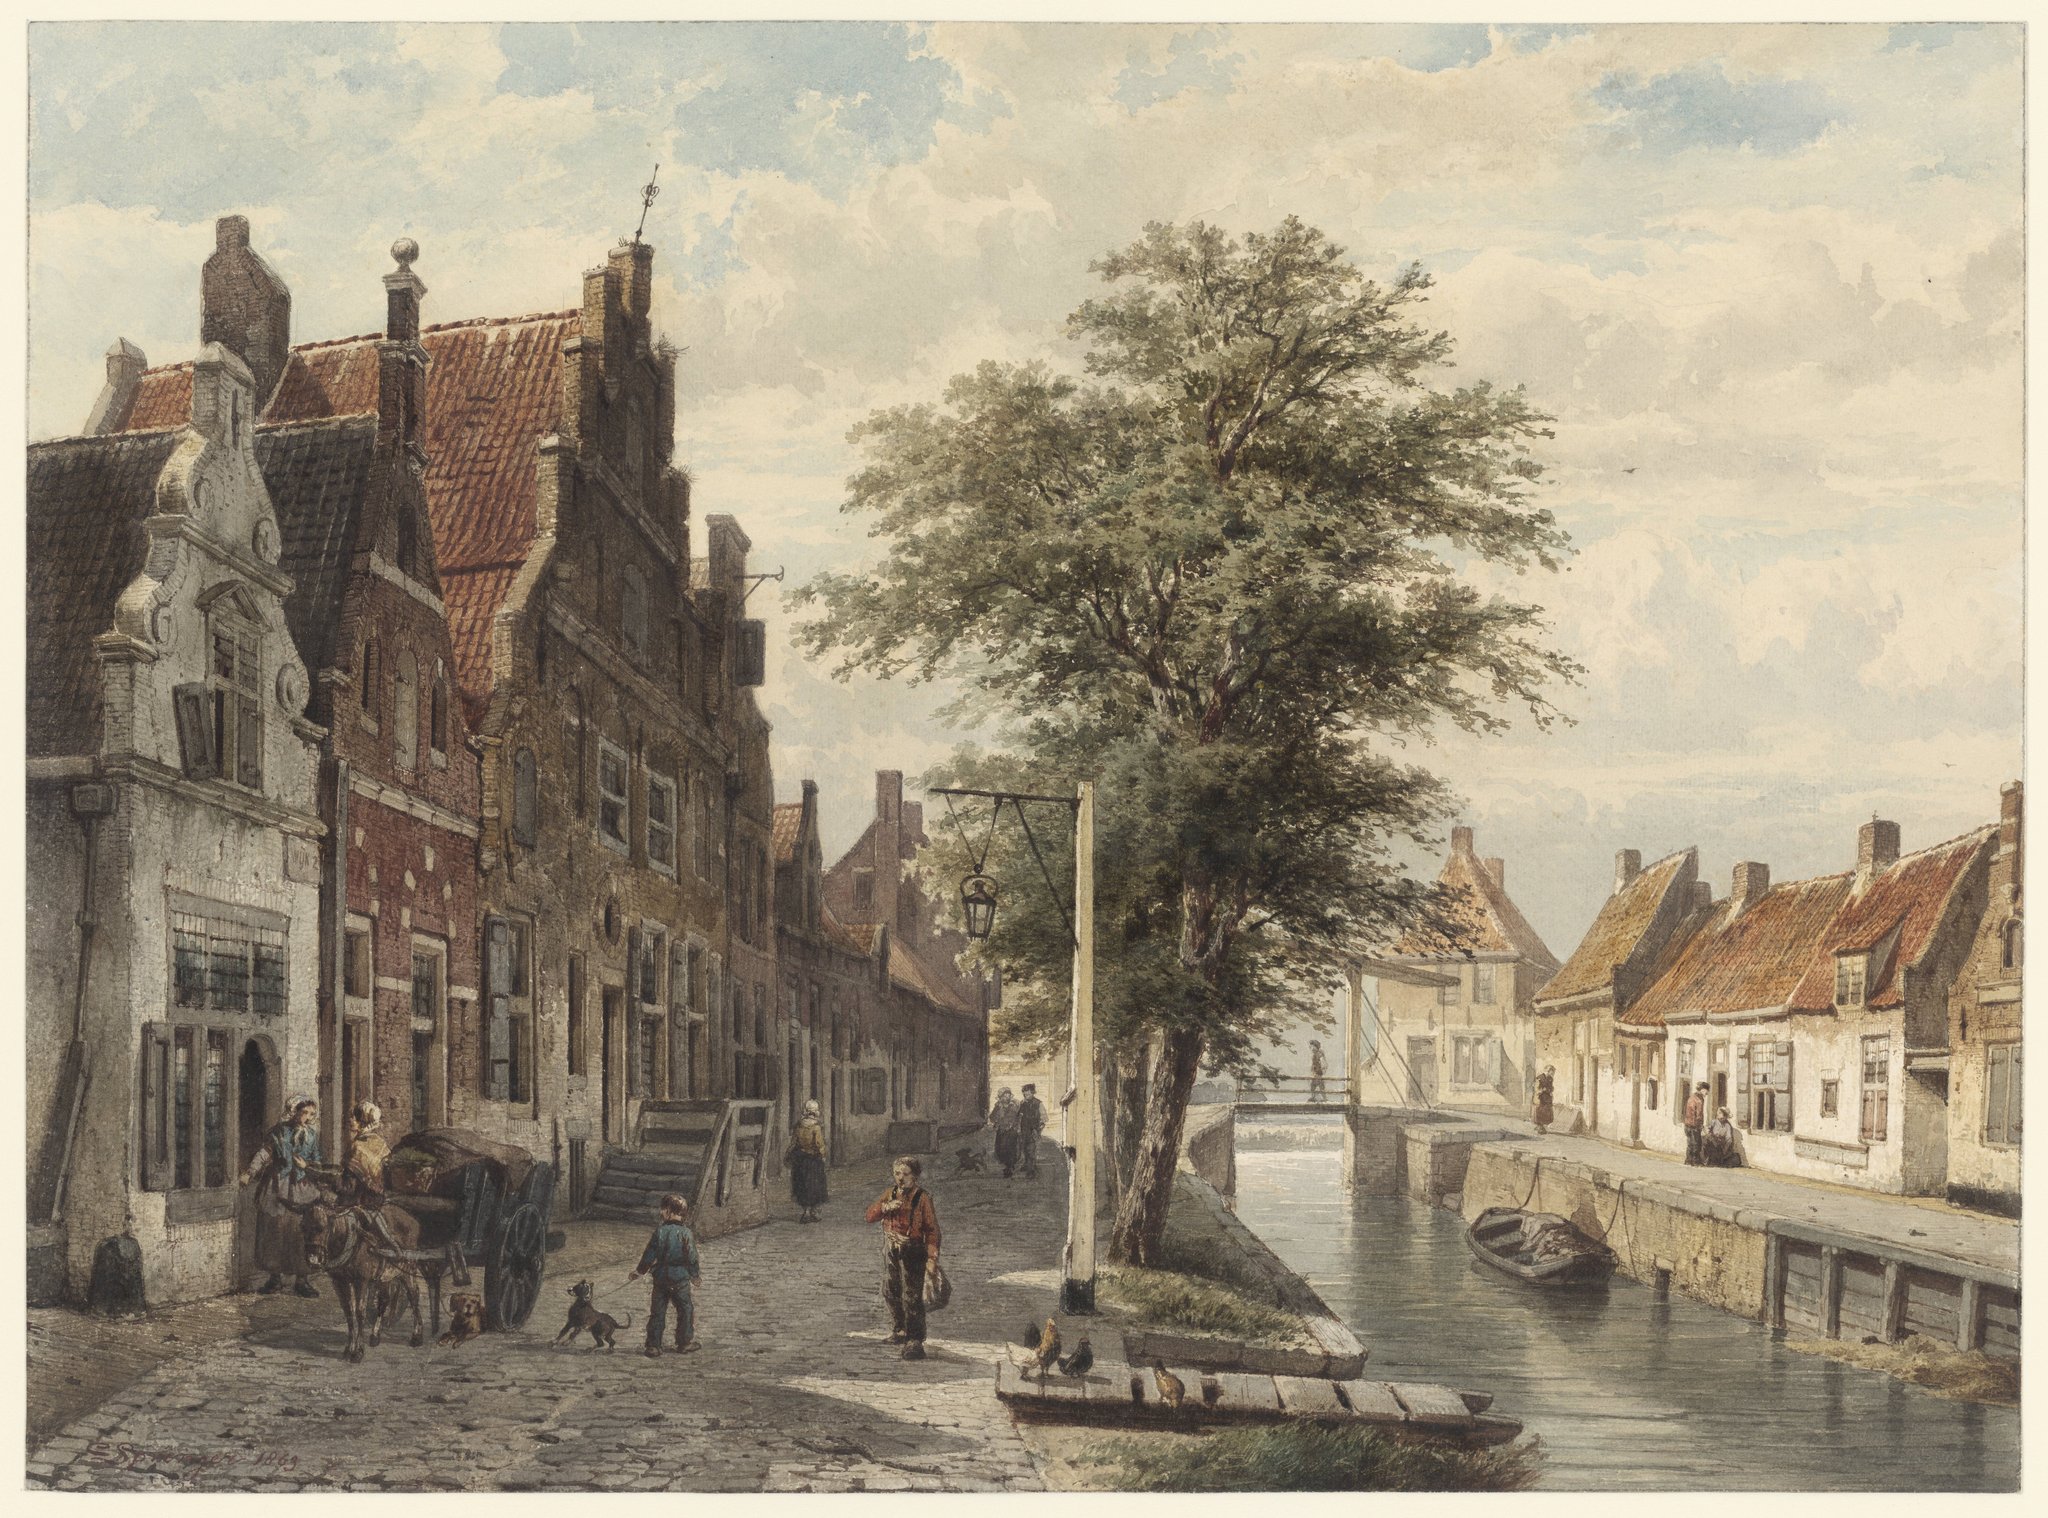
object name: watercolor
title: Gezicht op de gracht te Hasselt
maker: cornelis springer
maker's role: draughtsman, painter, print maker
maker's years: 1817-1891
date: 1863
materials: ink, paper, pencil, watercolor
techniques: brush, pen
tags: canals, waters (in city)